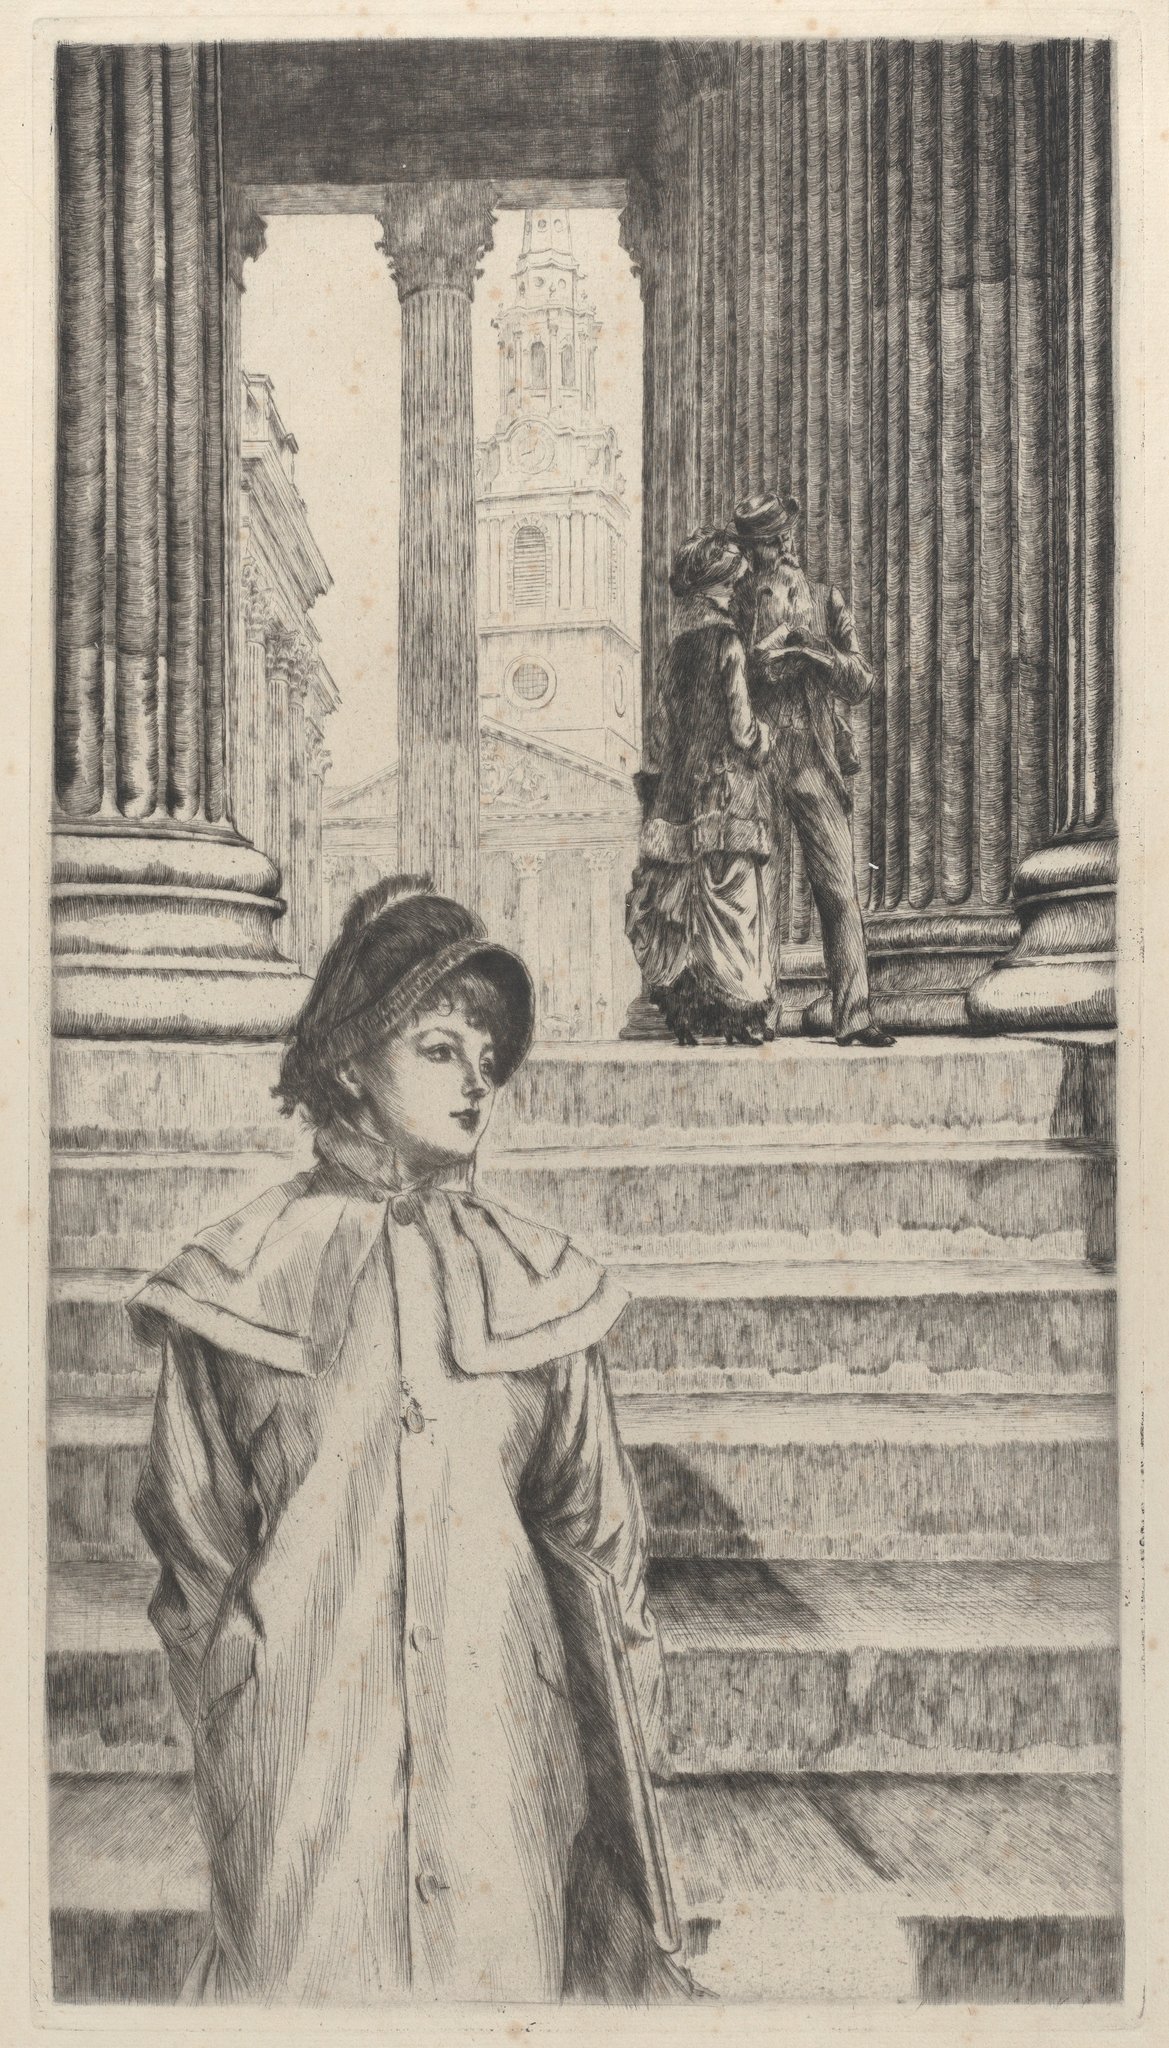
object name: print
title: The Portico of the National Gallery, London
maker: james tissot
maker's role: artist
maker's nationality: french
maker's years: 1836-1902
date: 1878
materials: paper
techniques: drypoint, etching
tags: men,women,london